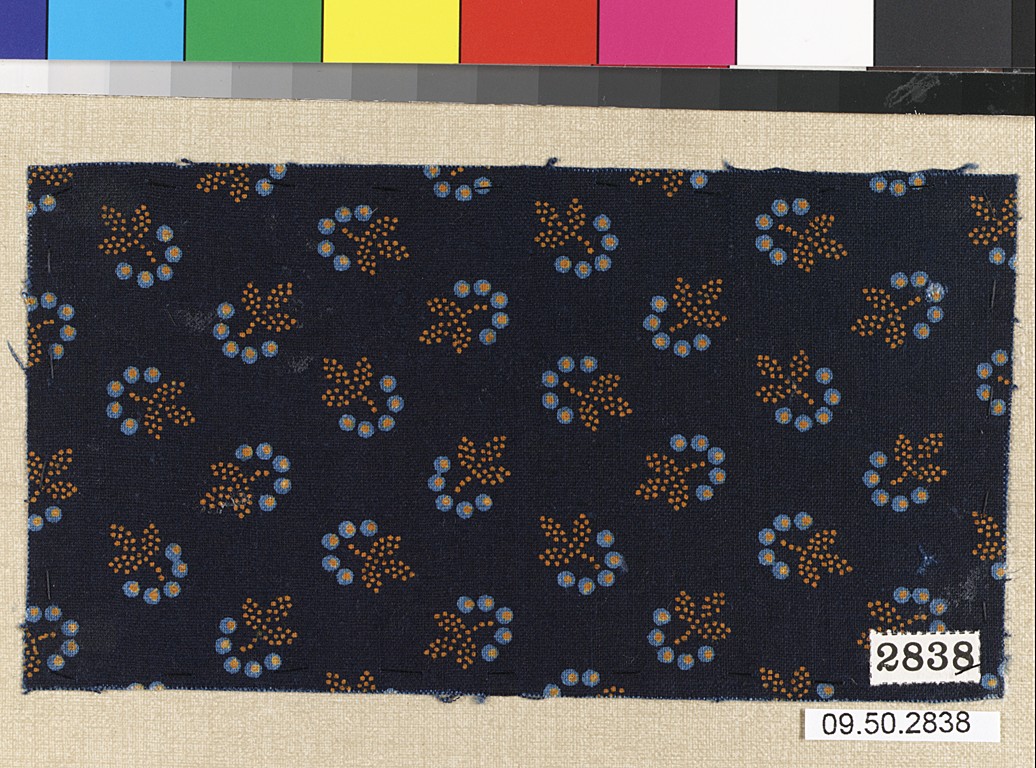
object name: piece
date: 1801-1900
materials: cotton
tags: leaves